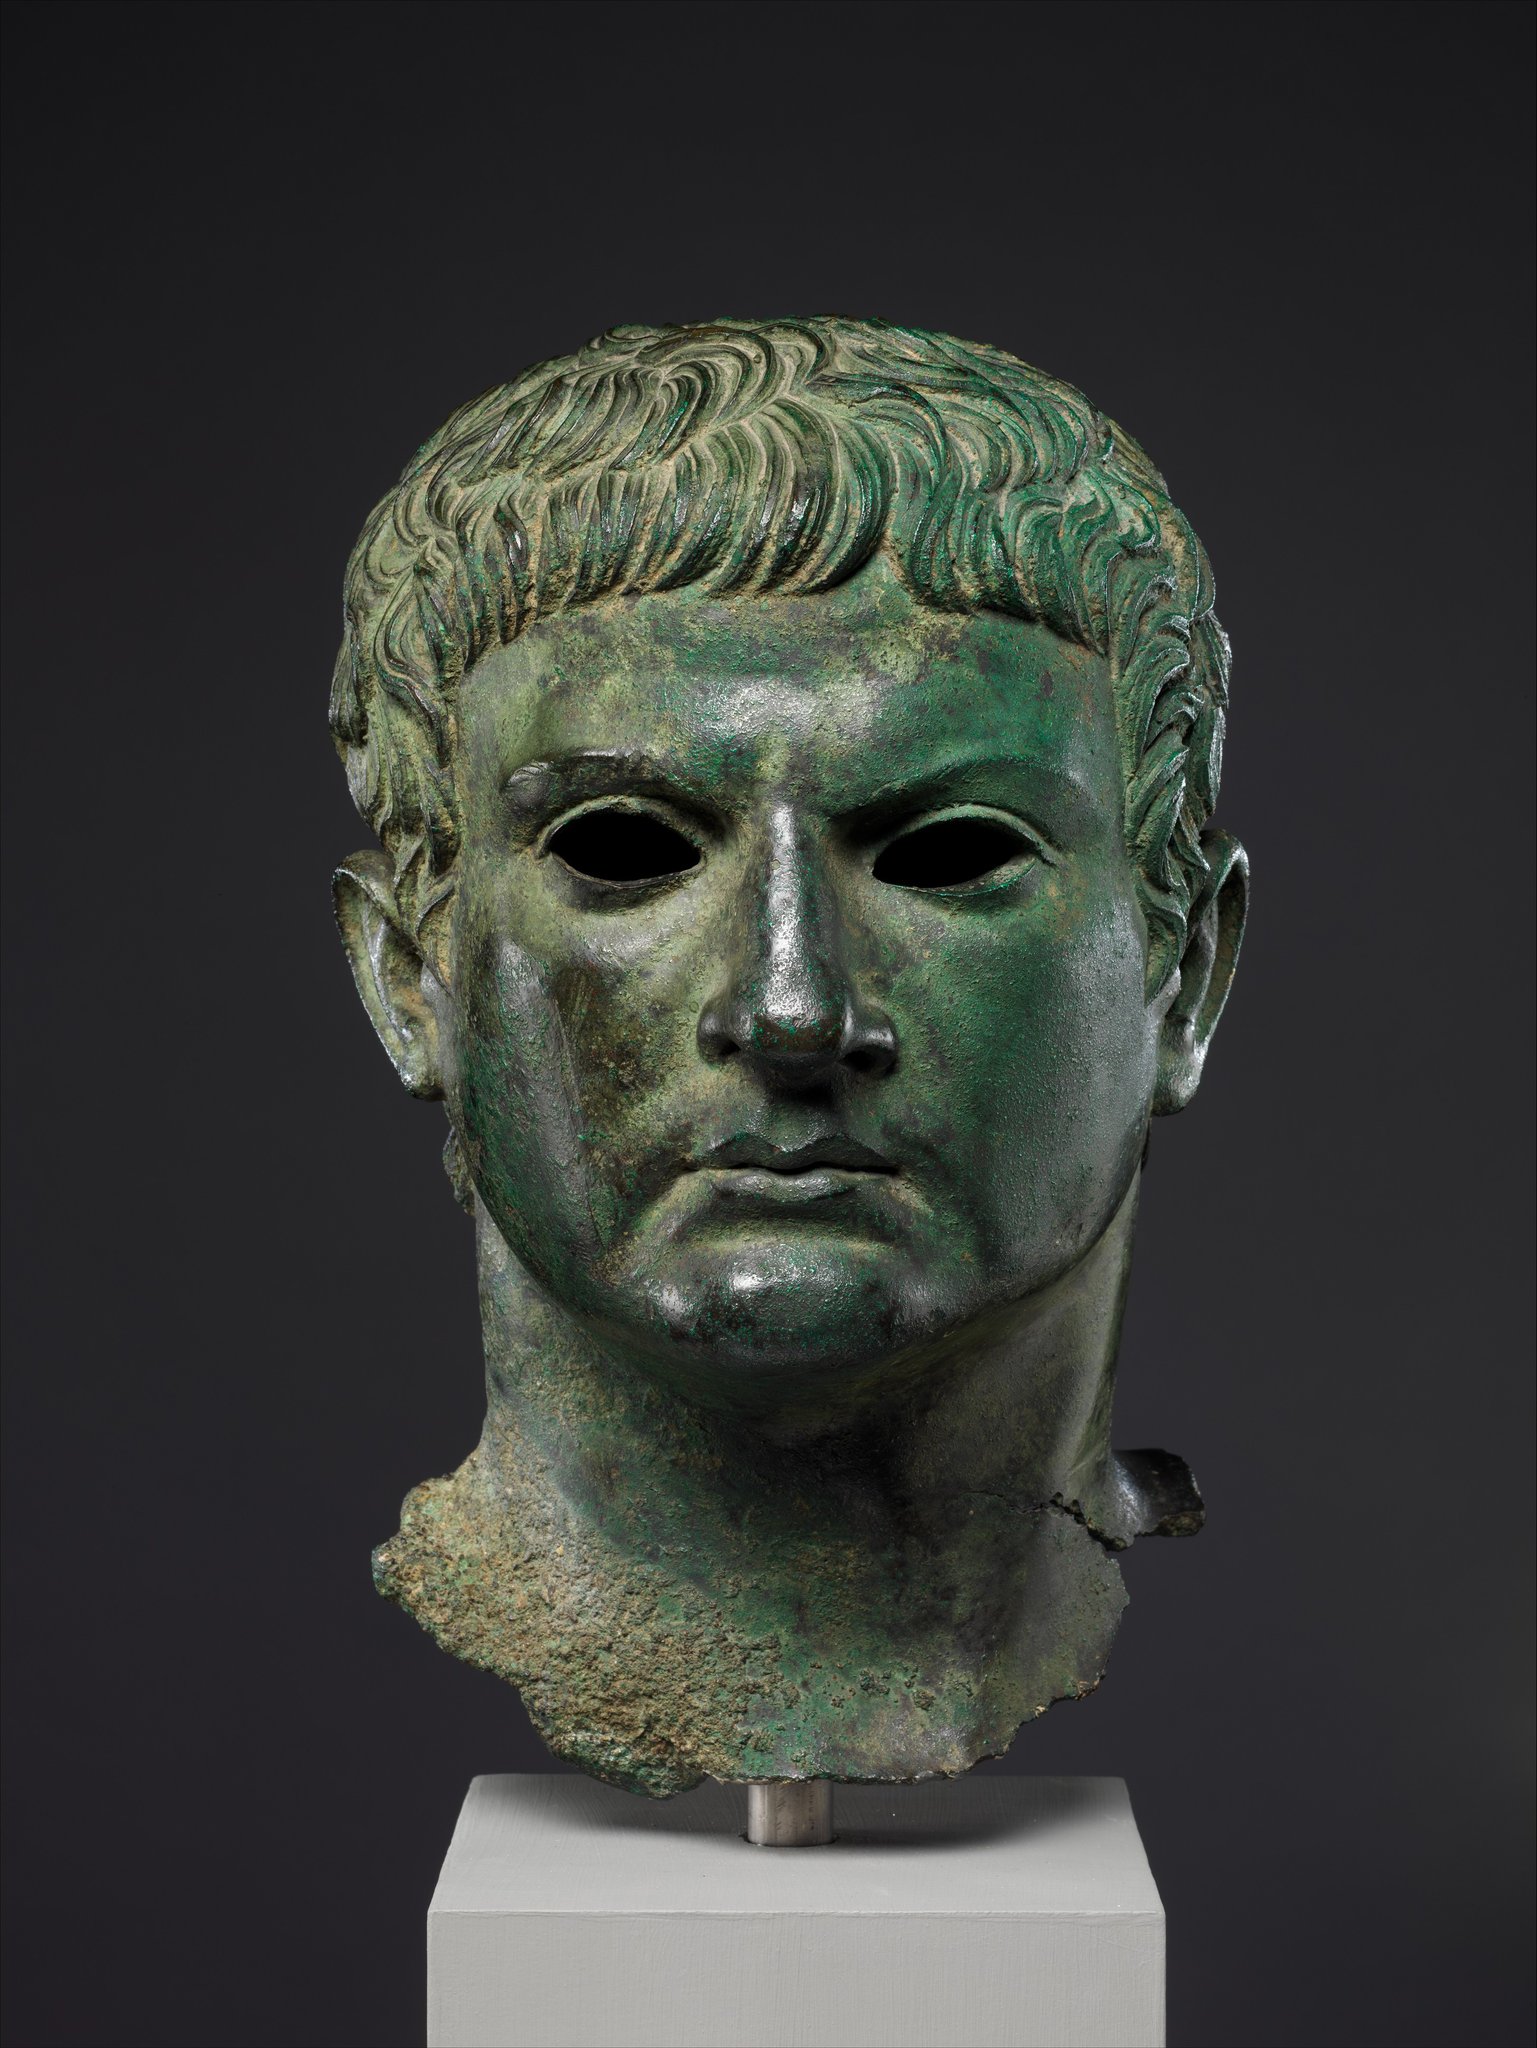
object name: portrait bust of a man agrippa marcus antonius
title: Bronze portrait of a man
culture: roman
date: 1-50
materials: bronze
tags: men,portraits